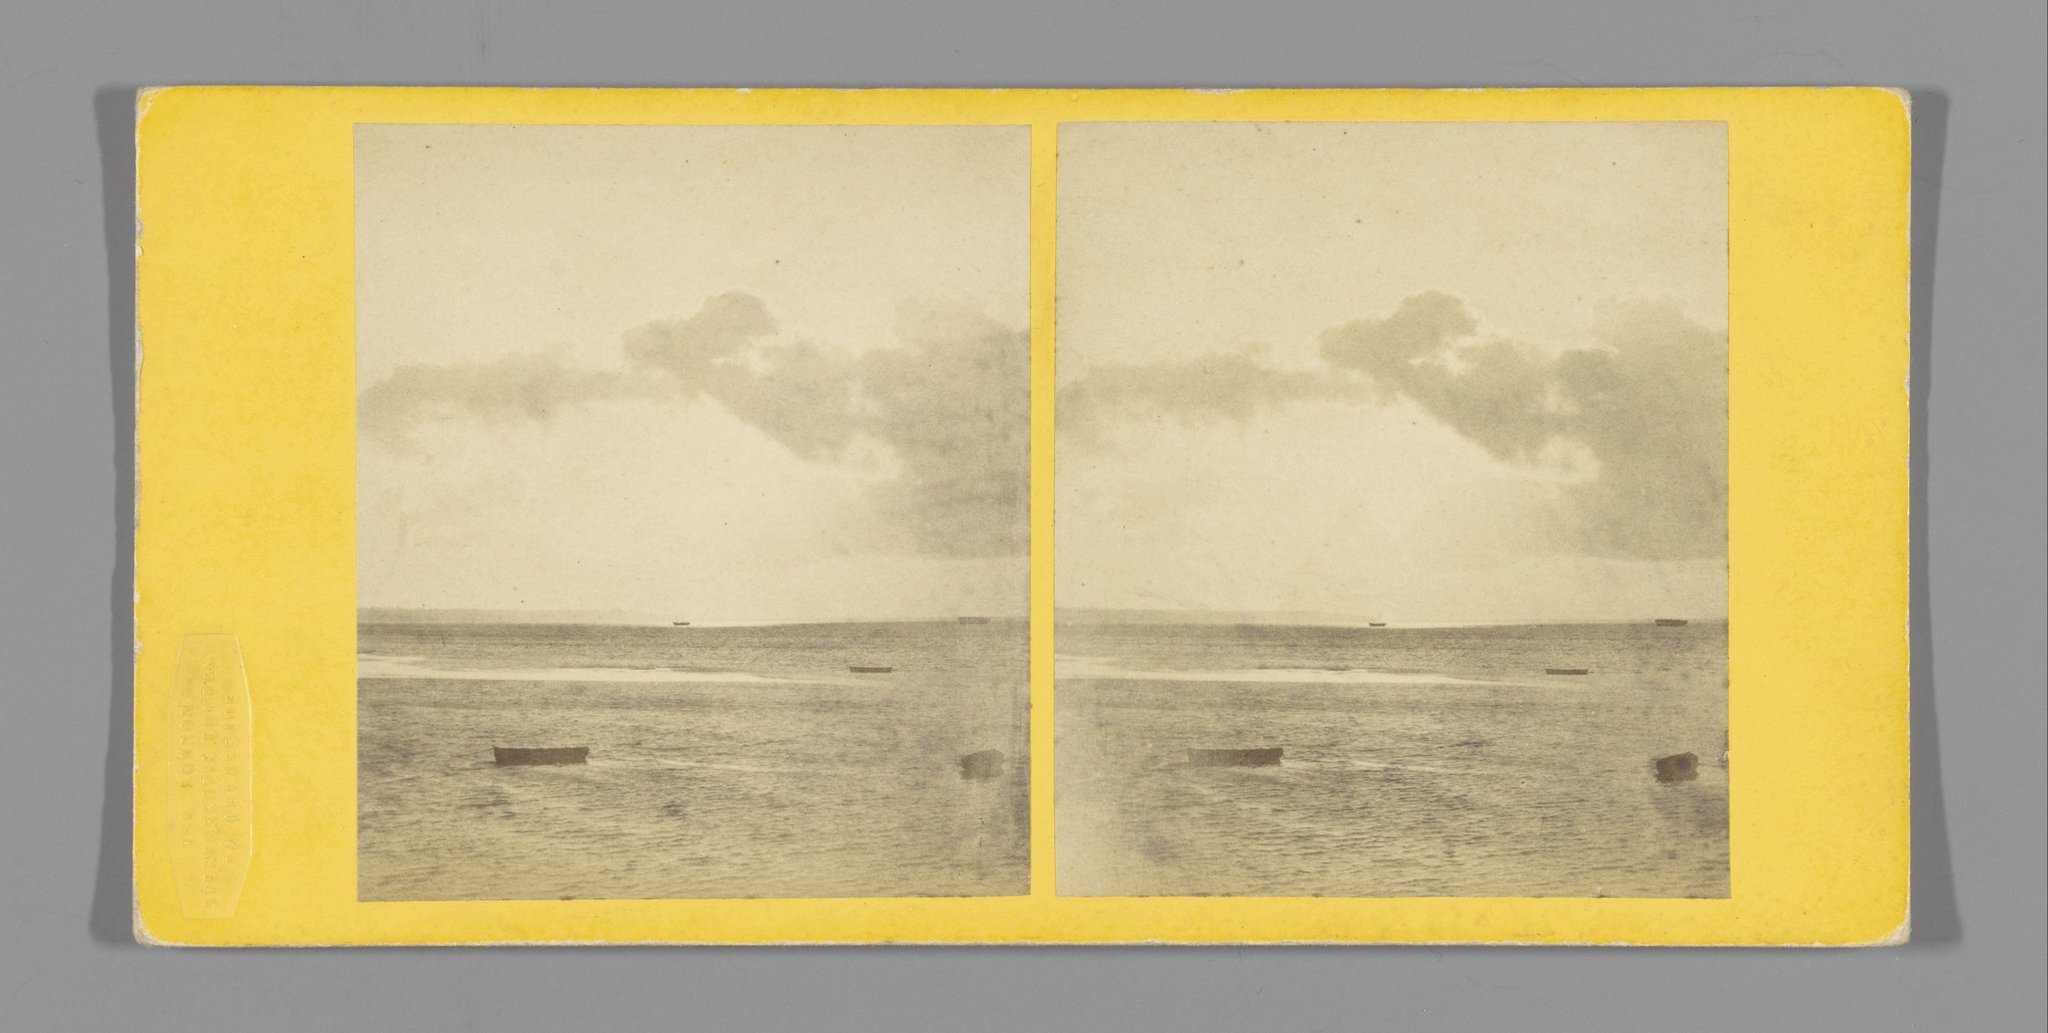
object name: stereograph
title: Zeegezicht vanaf de Ryde Pier op het Isle of Wight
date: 1850-1880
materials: cardboard, photographic support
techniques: albumen print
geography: isle of wight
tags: sea (seascape)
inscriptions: name: ‘The London Stereoscopic Company 54. Cheapside’, number: ‘No. 240.’, inscription: ‘(Instantaneous.)’